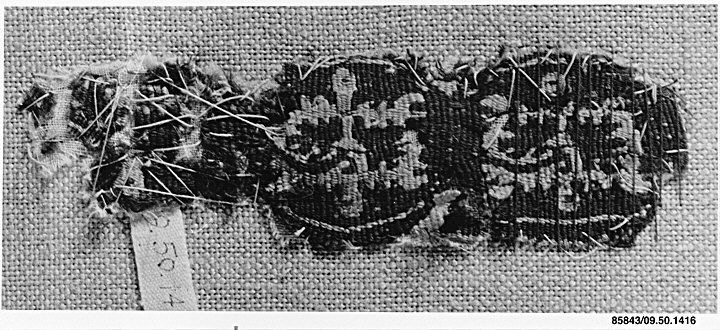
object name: band fragment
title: Fragment of a Band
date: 301-500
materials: linen, wool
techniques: weave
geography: egypt